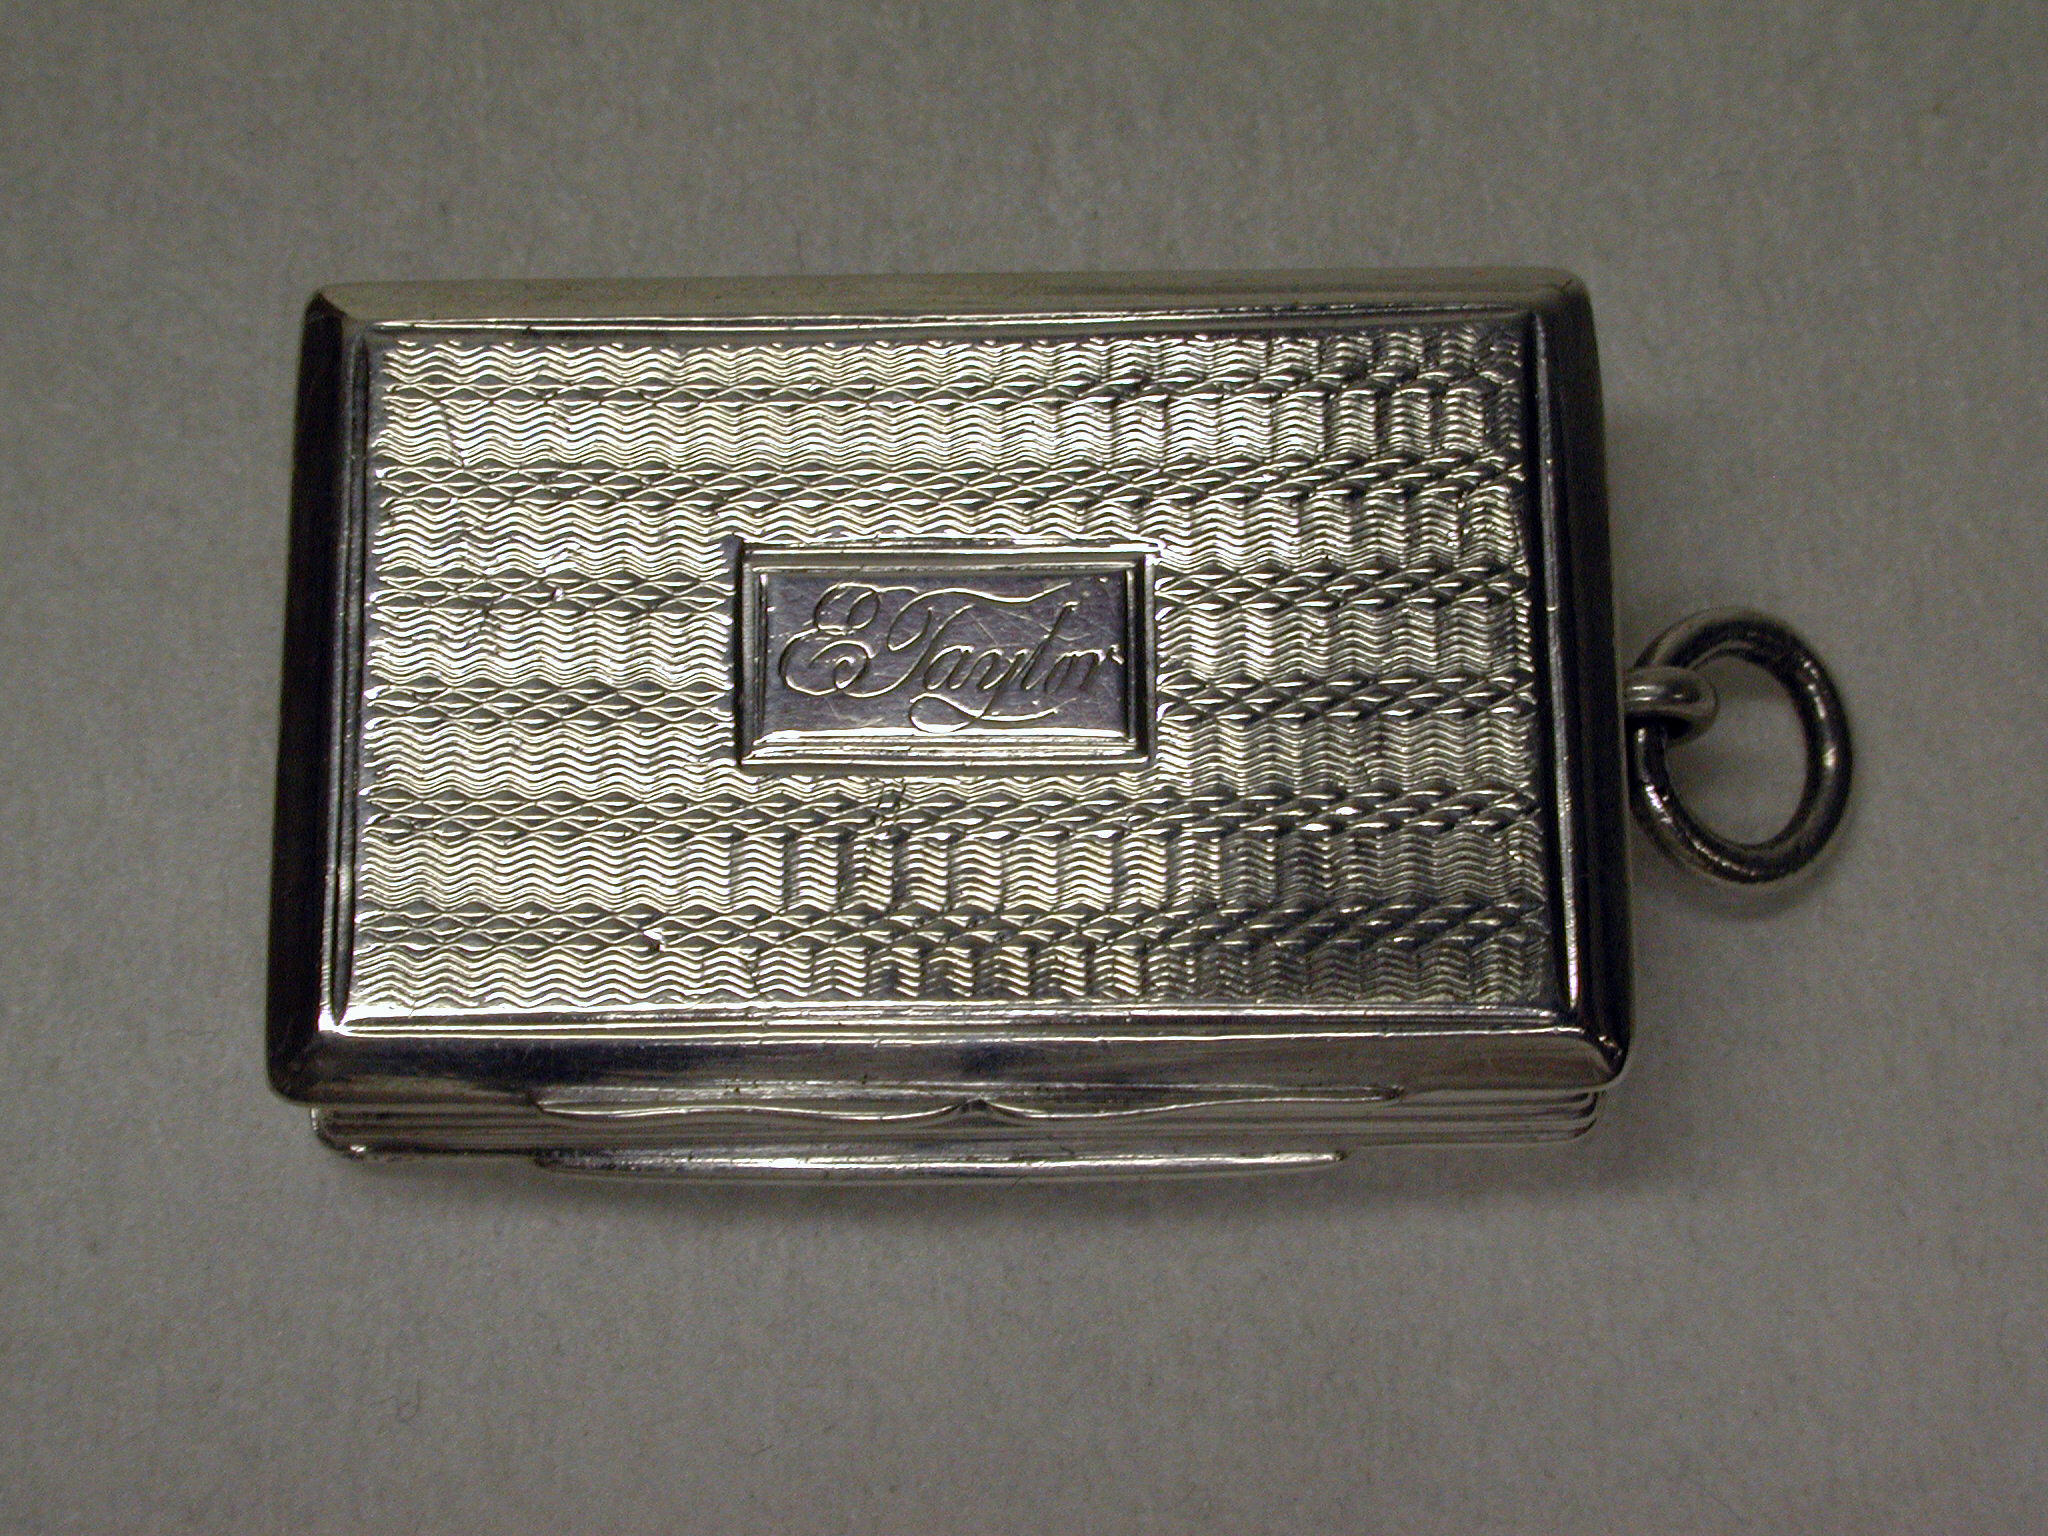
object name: vinaigrette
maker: thomas shaw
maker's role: maker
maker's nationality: british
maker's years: 1818-1845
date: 1830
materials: silver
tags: flowers